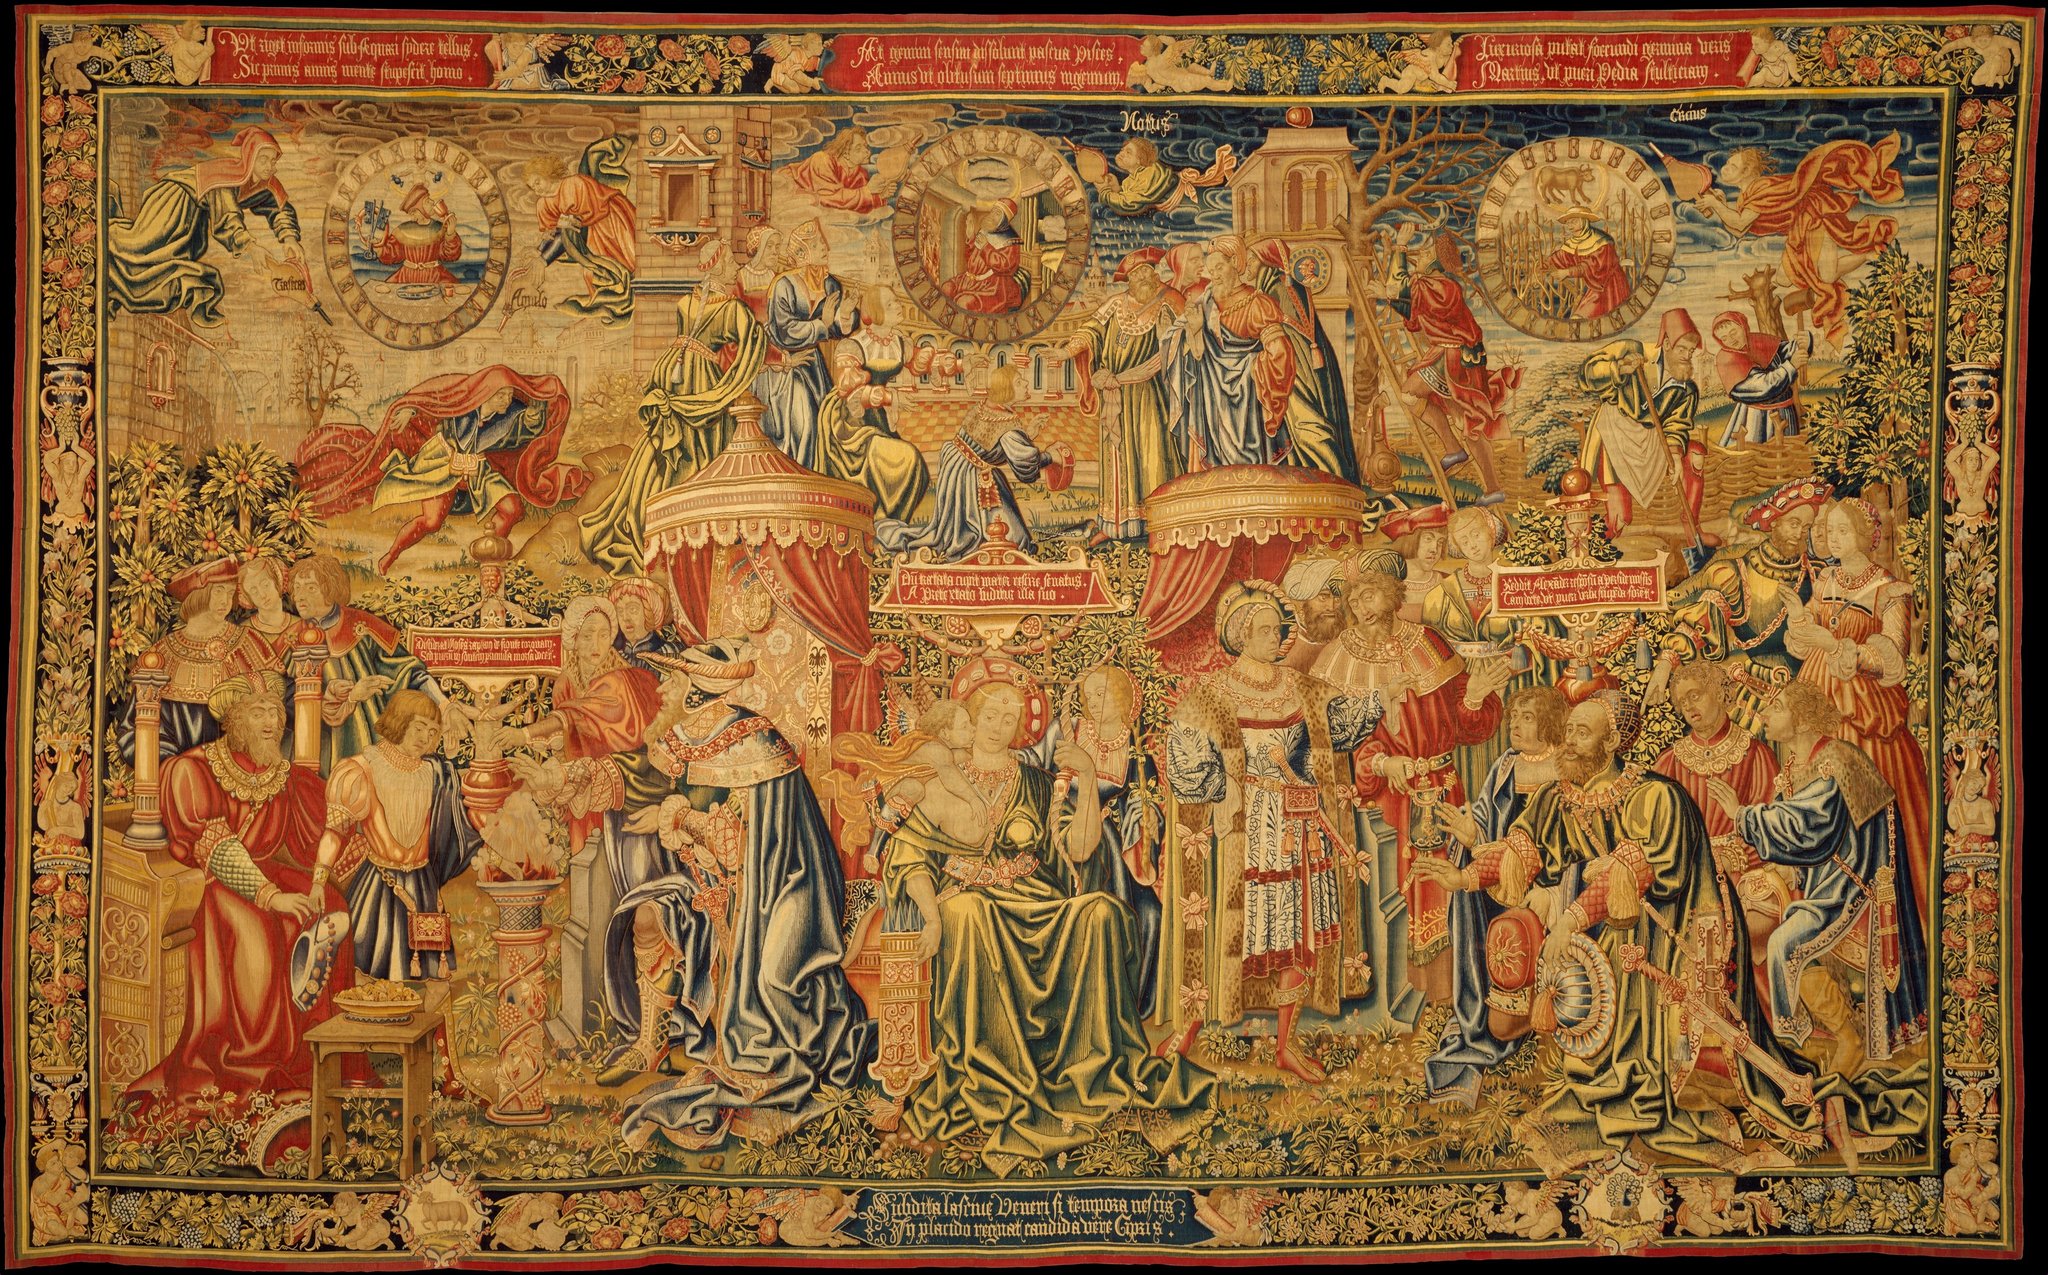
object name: tapestry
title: The Twelve Ages of a Man: The First Three Ages (Birth-18), or Spring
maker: bernard van orley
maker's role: designer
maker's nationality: netherlandish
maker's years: 1492-1542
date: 1515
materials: silk, wool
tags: men,women,working